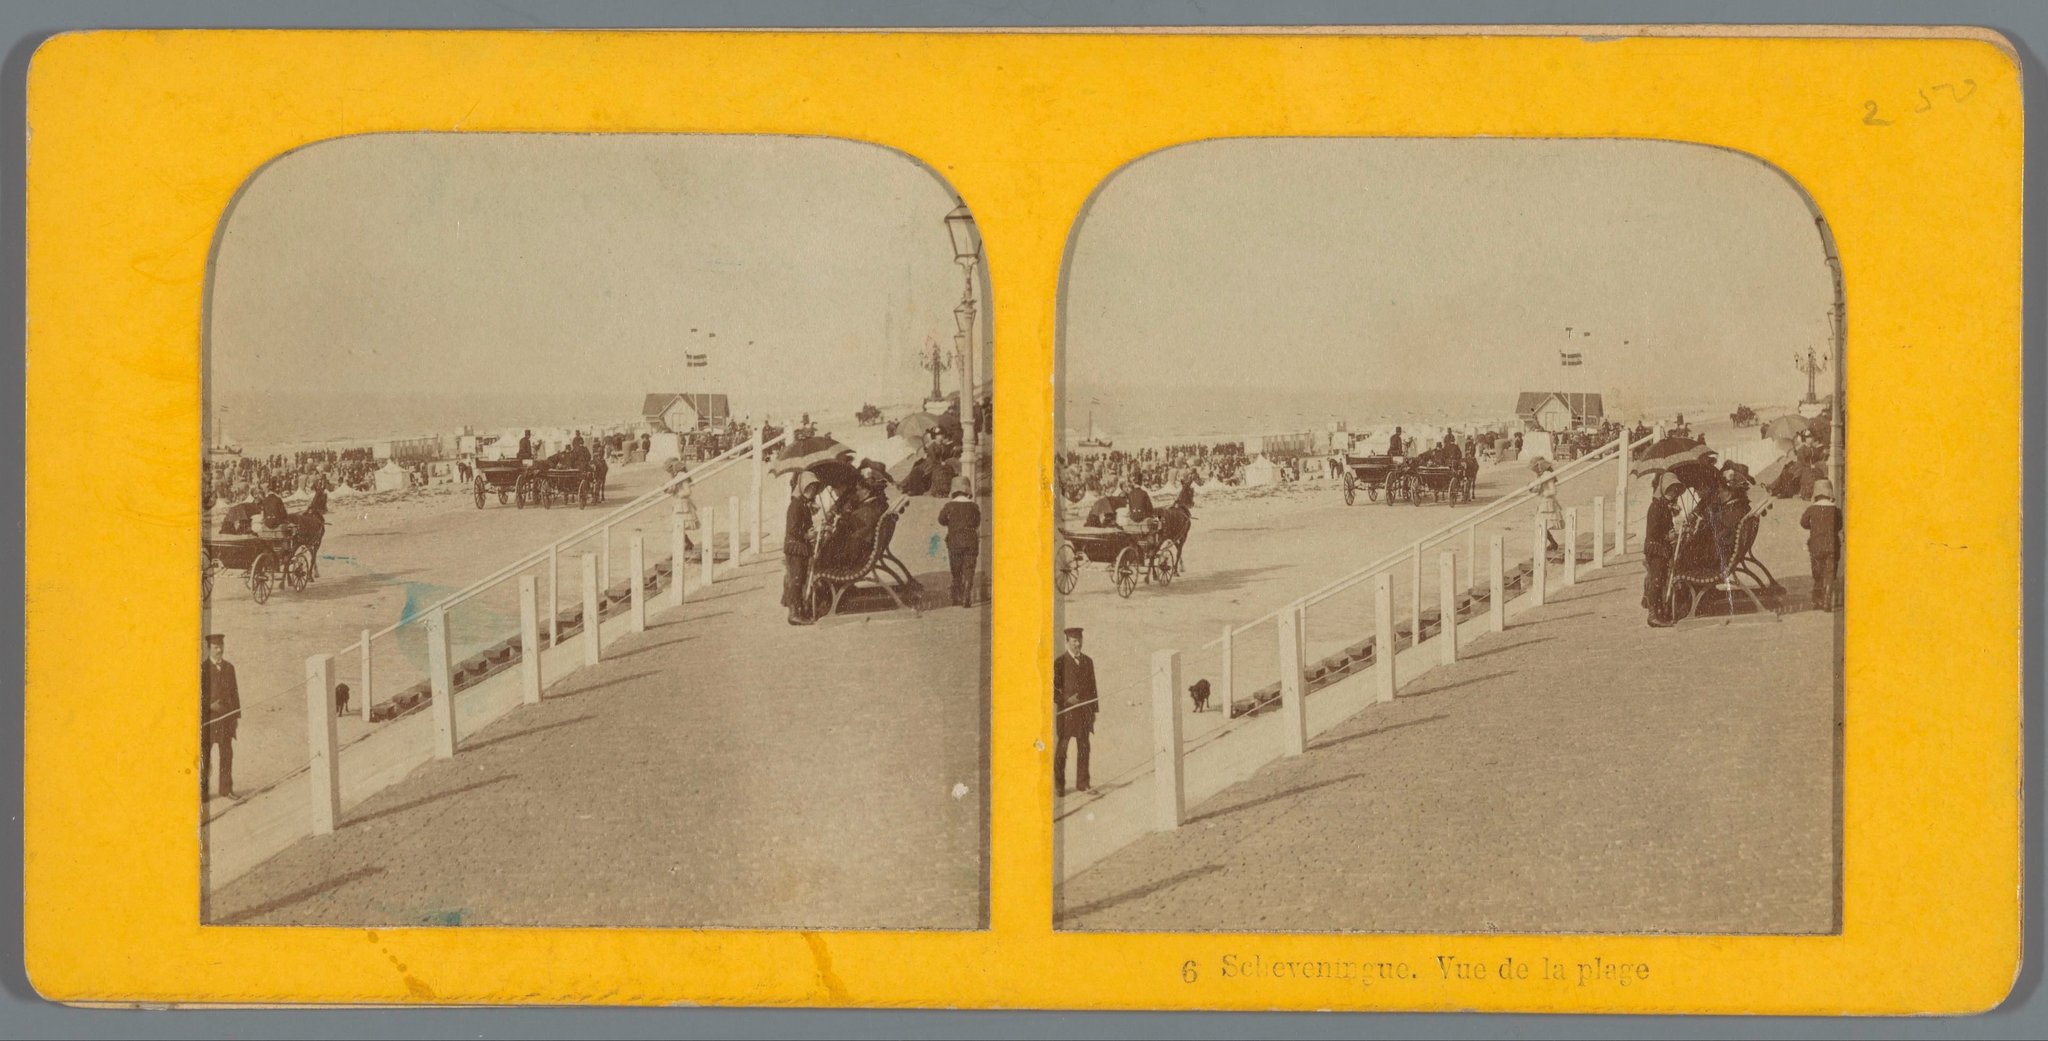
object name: tissue stereograph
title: Gezicht op het strand en de boulevard van Scheveningen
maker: Anonymous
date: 1855-1875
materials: cardboard, paper, photographic support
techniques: albumen print, cutting, hand coloring, perforating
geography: scheveningen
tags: beach (as place of recreation), four-wheeled vehicle drawn by one animal, avenue, boulevard, promenade, esplanade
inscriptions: number: ‘6’, number: ‘9’